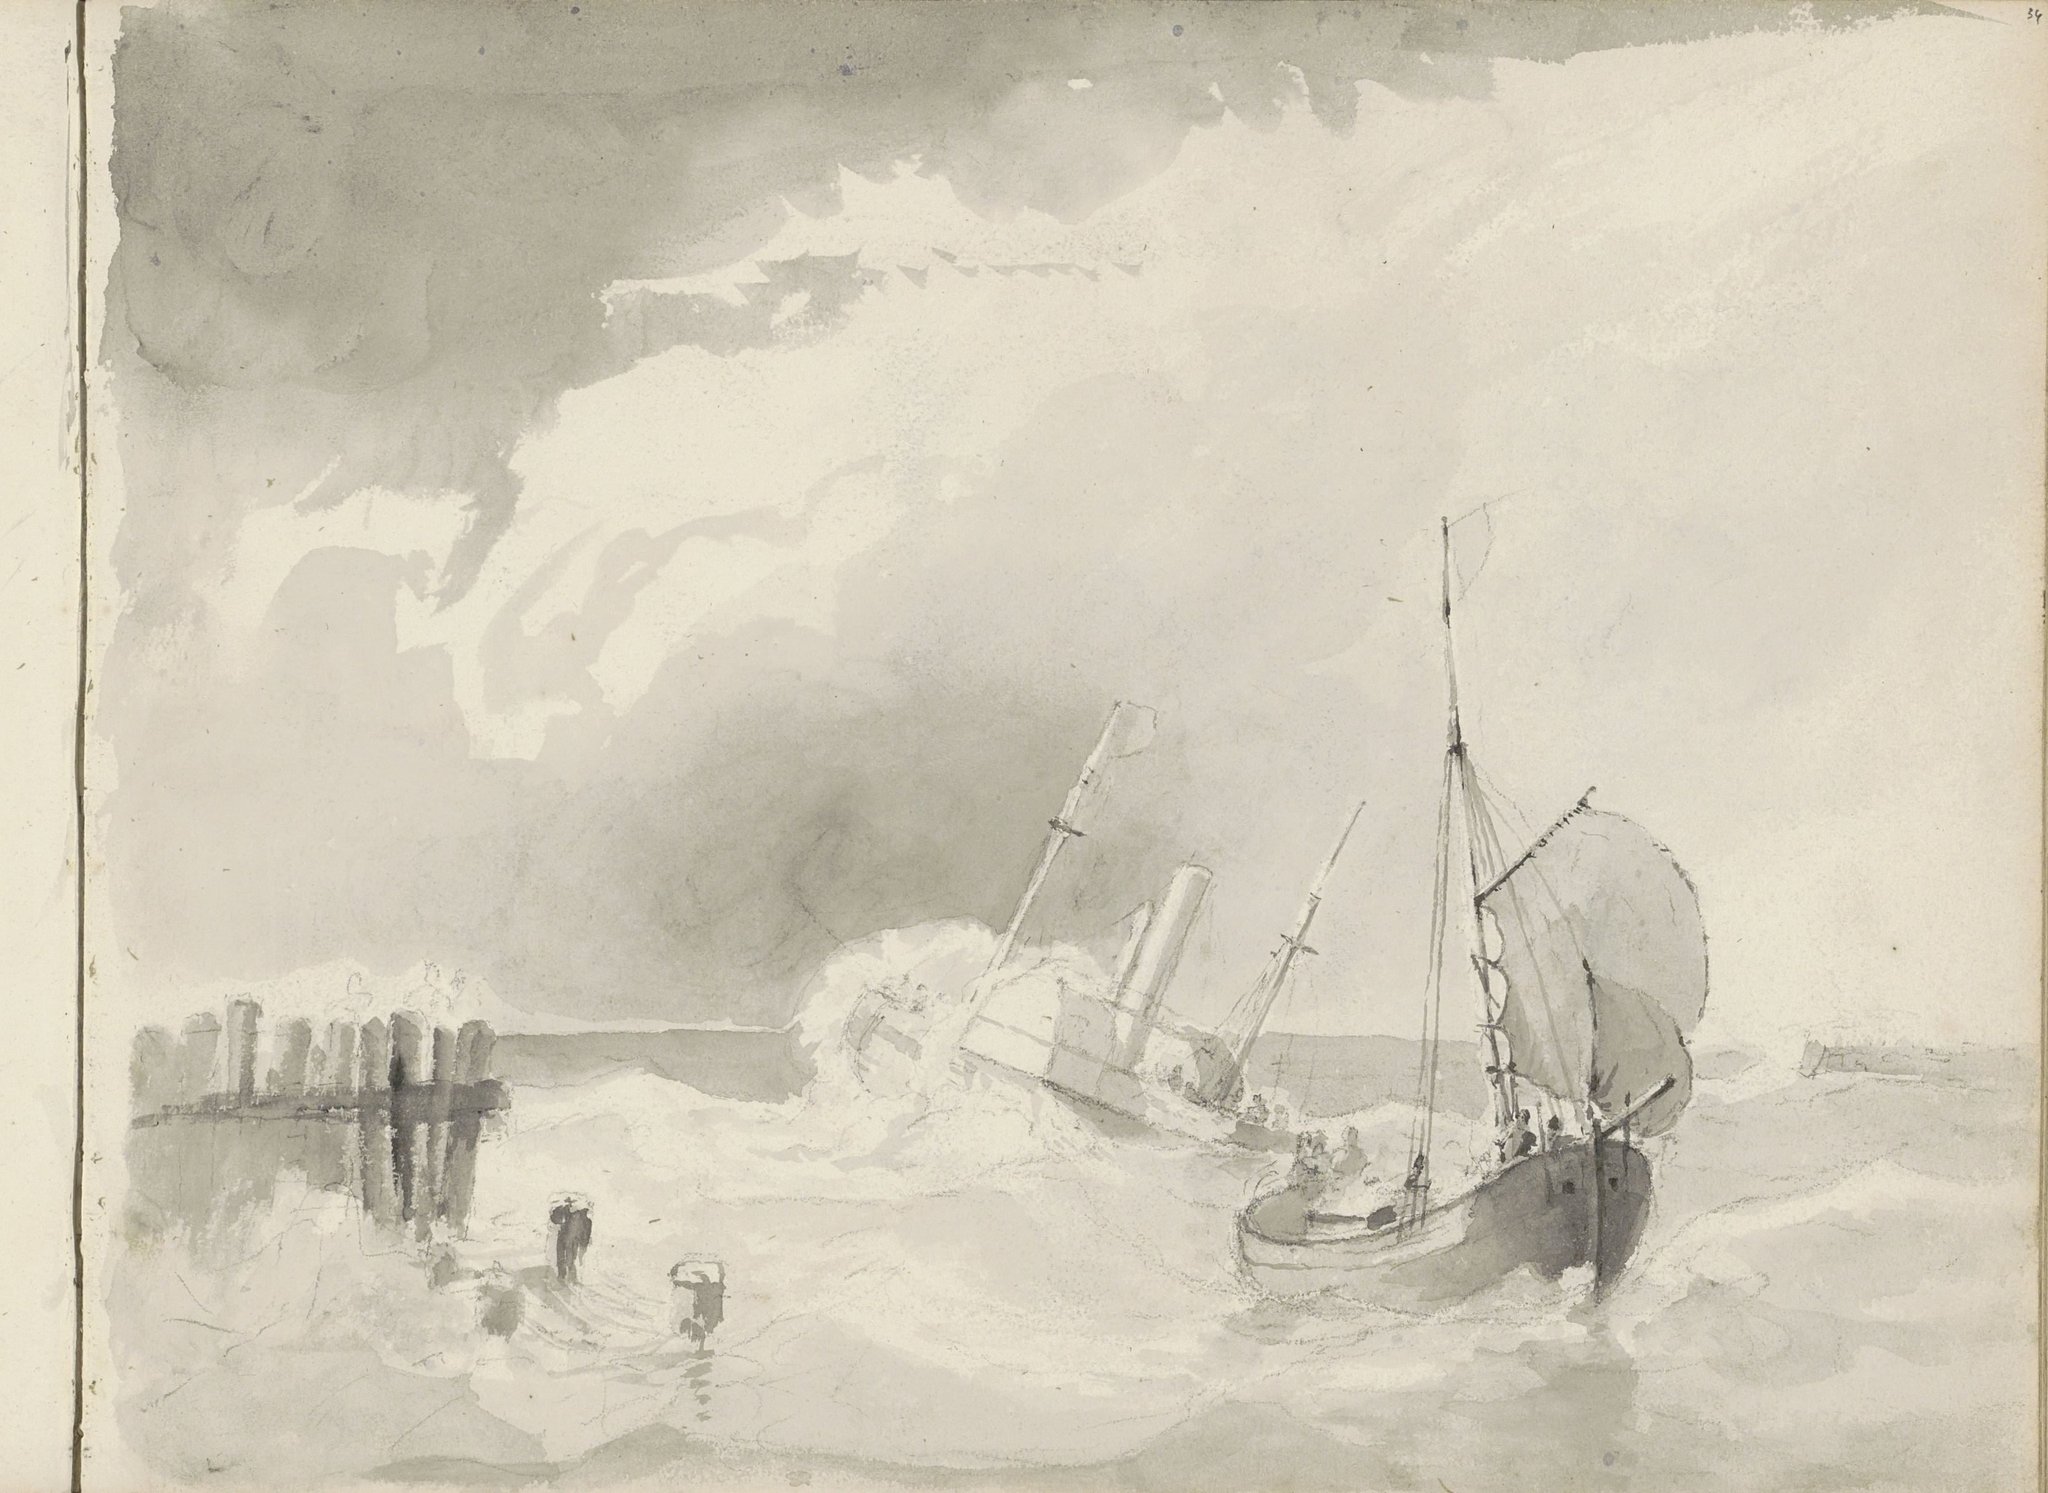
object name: sketchbook leaf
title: Schip in nood voor een kust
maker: petrus johannes schotel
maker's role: draughtsman, painter, print maker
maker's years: 1808-1865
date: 1825-1875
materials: ink, paper, pencil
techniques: brush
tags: shipwreck, coast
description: Blad 34 recto uit een schetsboek met 44 bladen.